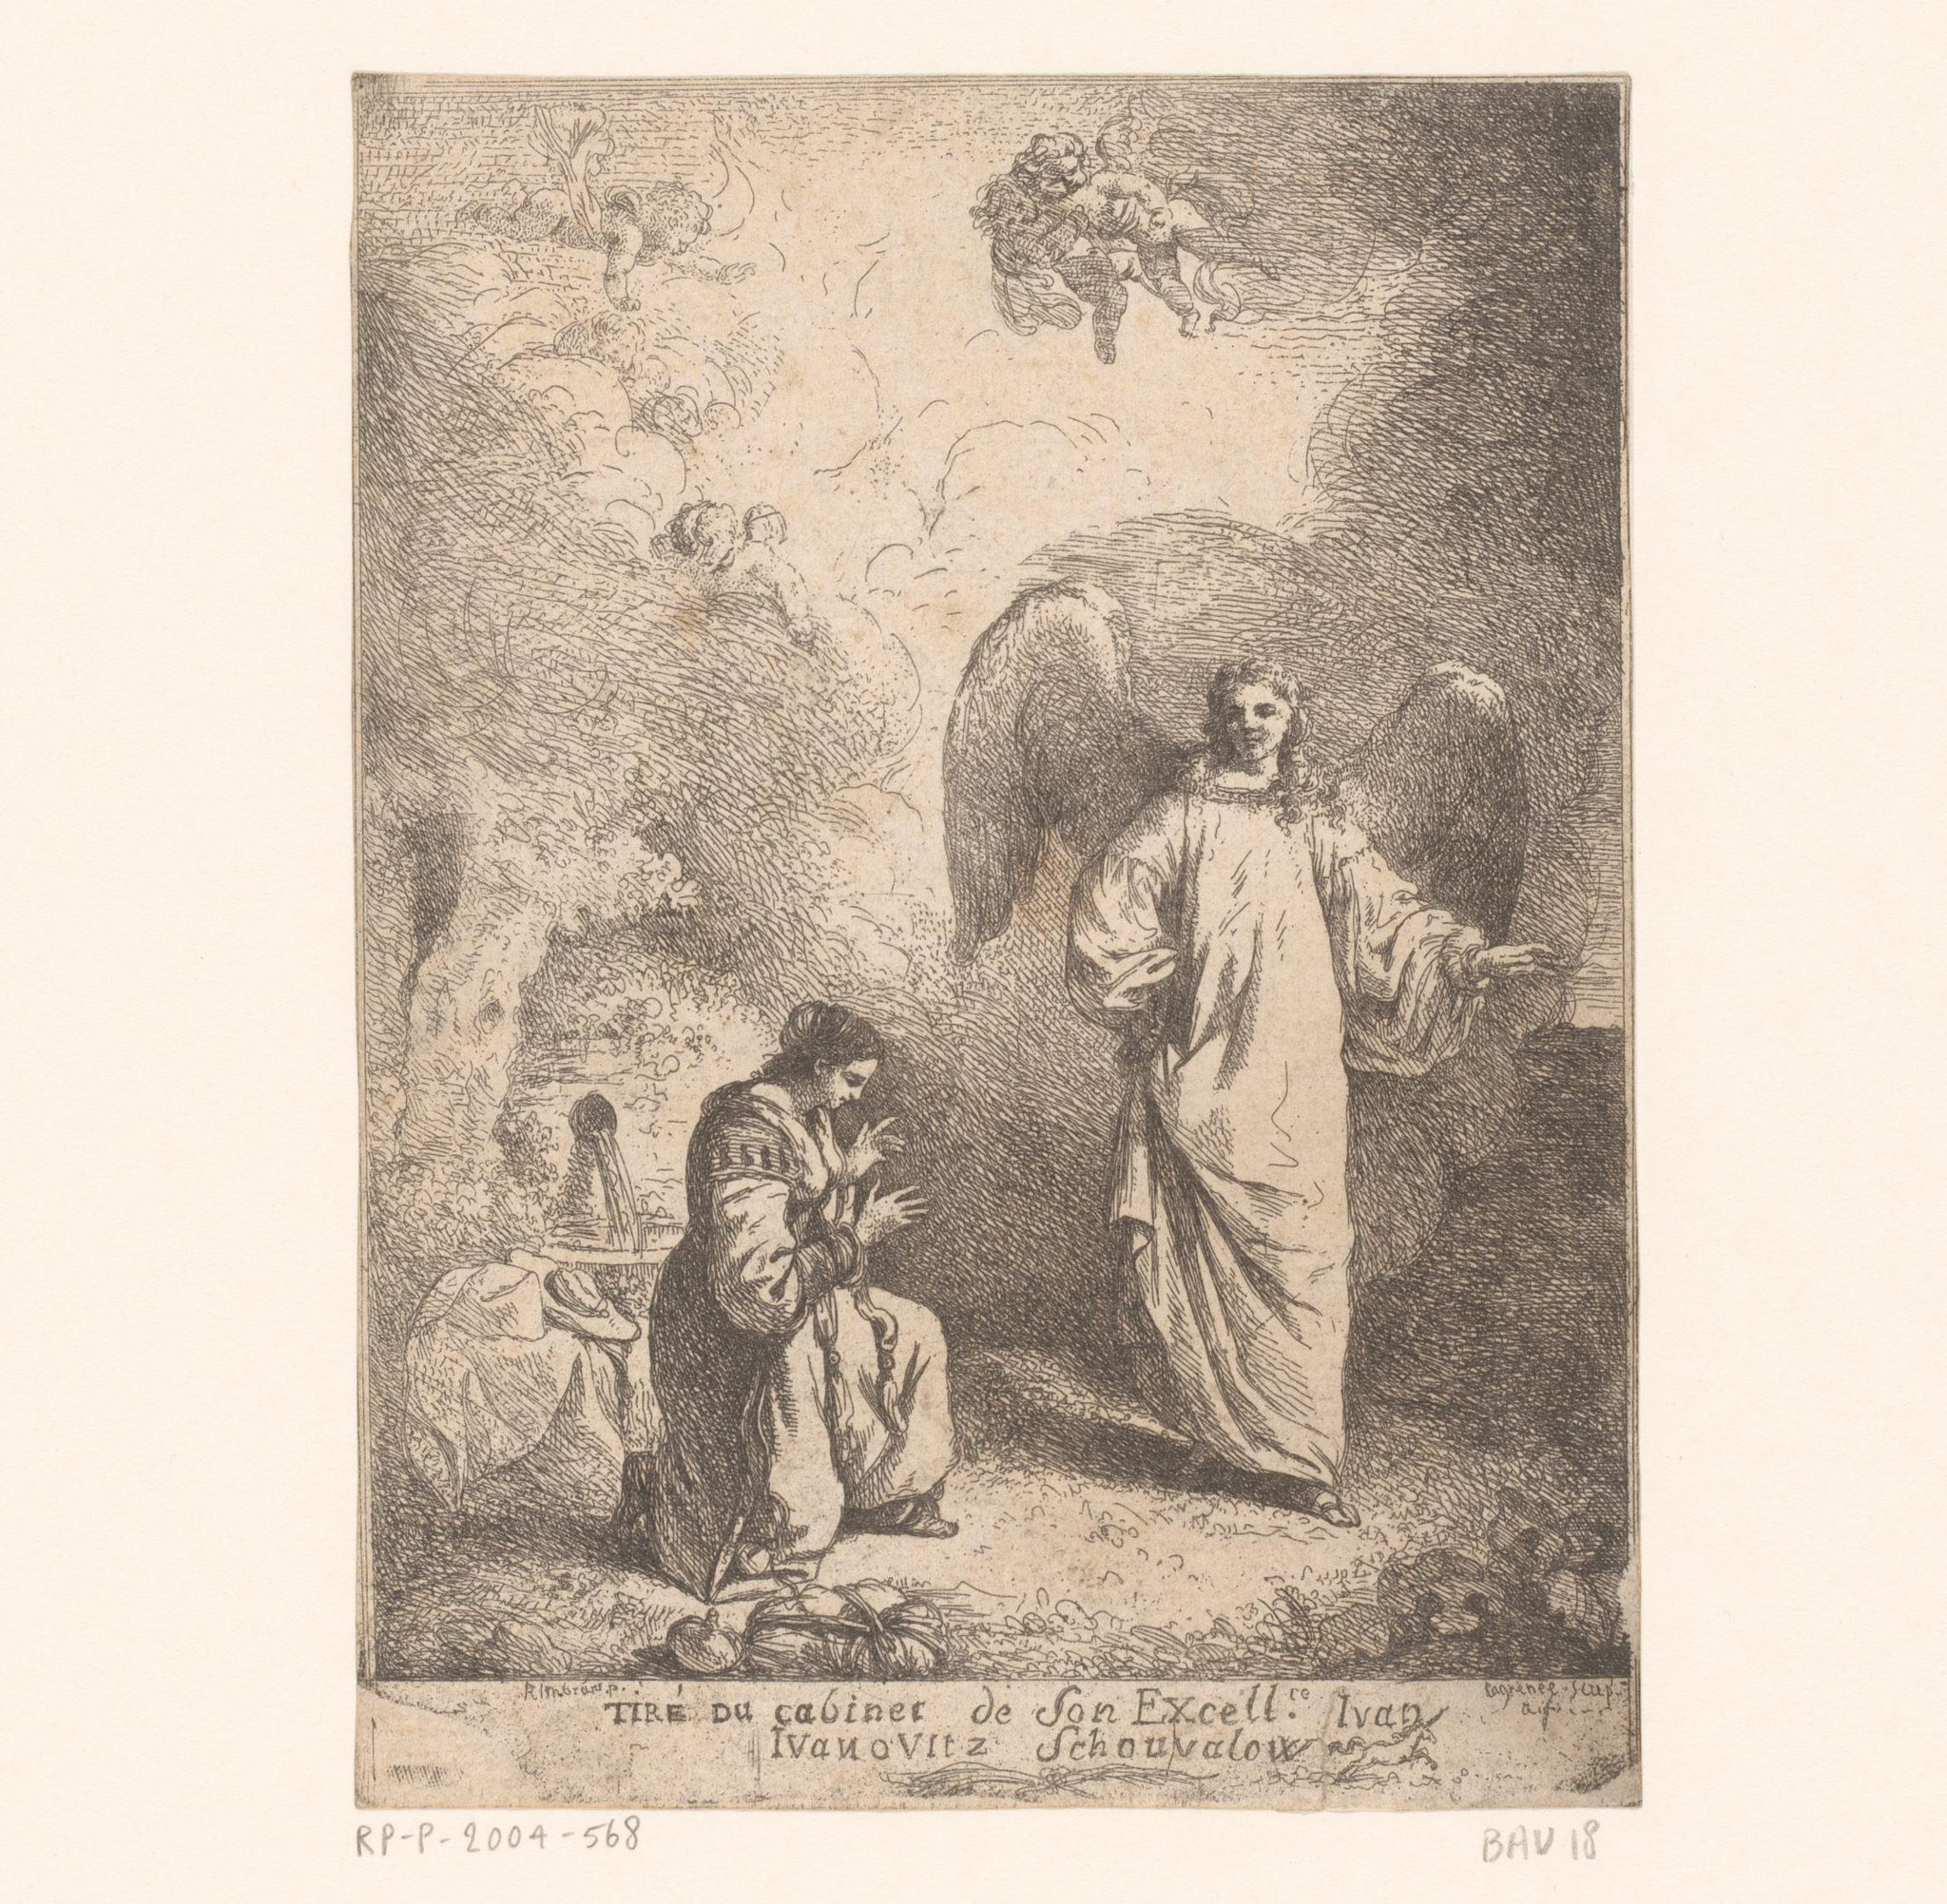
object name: print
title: Annunciatie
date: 1749-1829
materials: paper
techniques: etching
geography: france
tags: mary (alone) reading, praying, etc. ~ annunciation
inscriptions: collector's mark: Lugt 2228, collector's mark: Lugt 2760